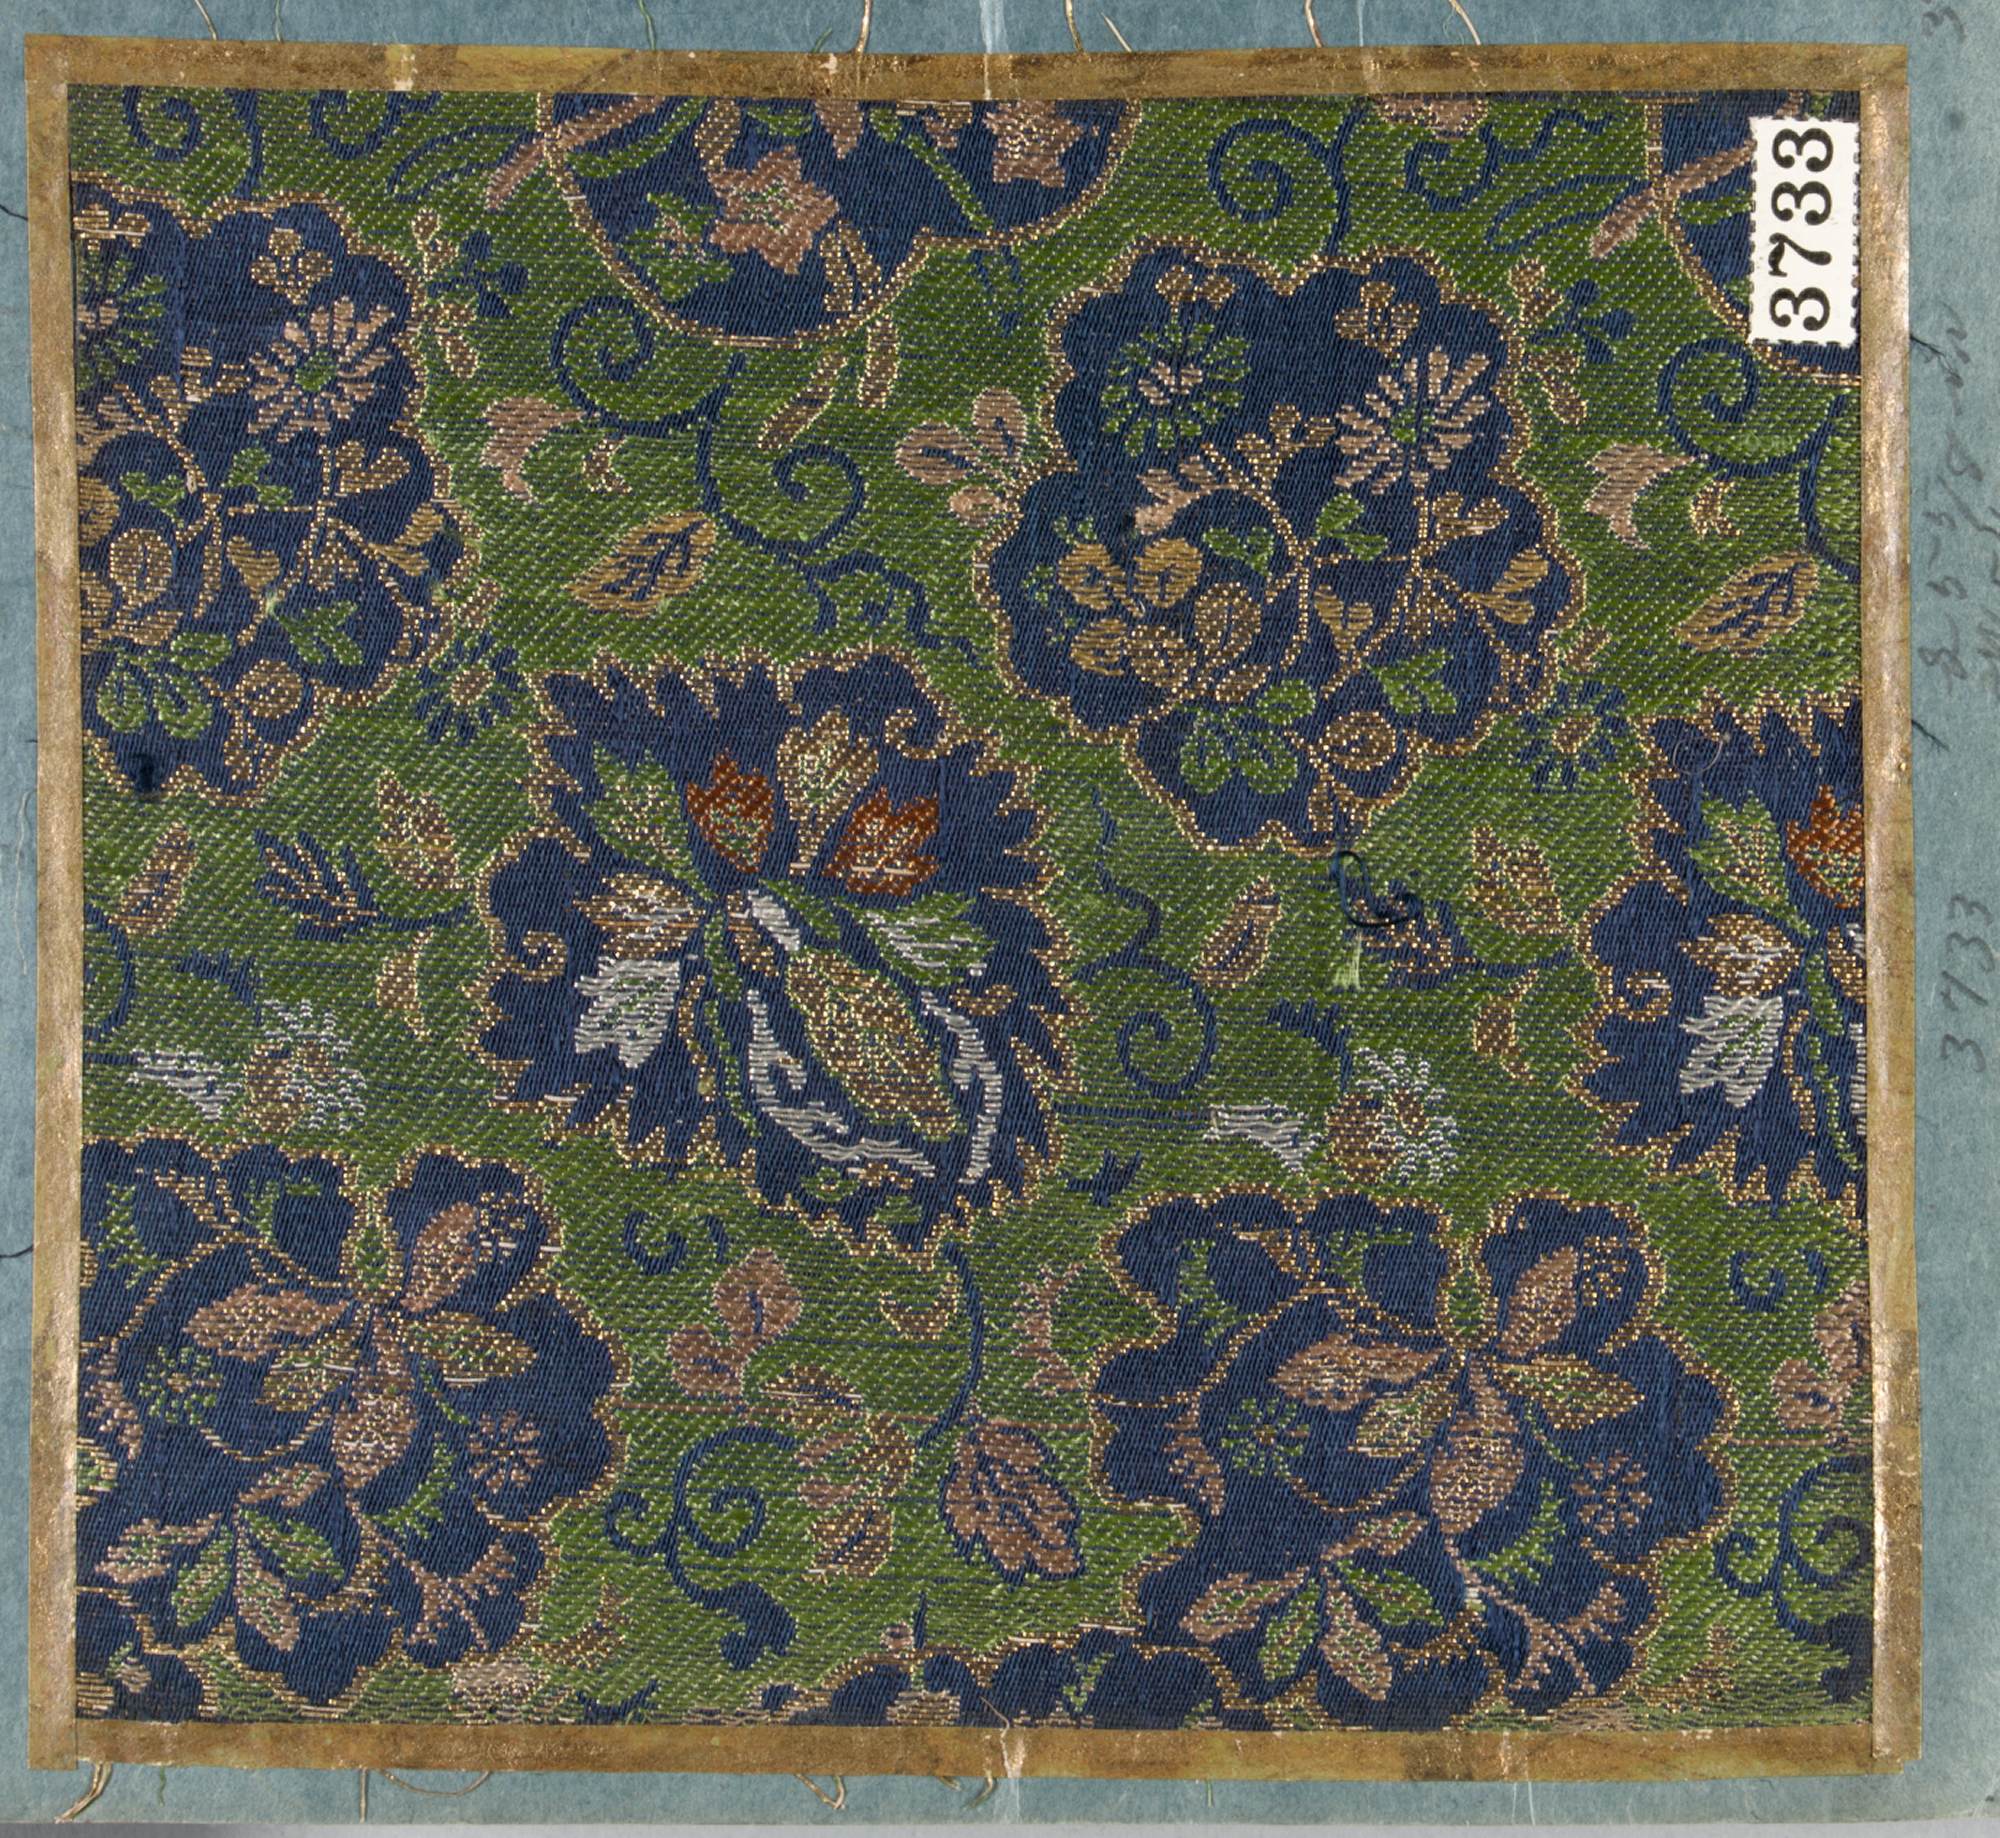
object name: sample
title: Textile Sample from Sample Book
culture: japanese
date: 1801-1900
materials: silk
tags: flowers